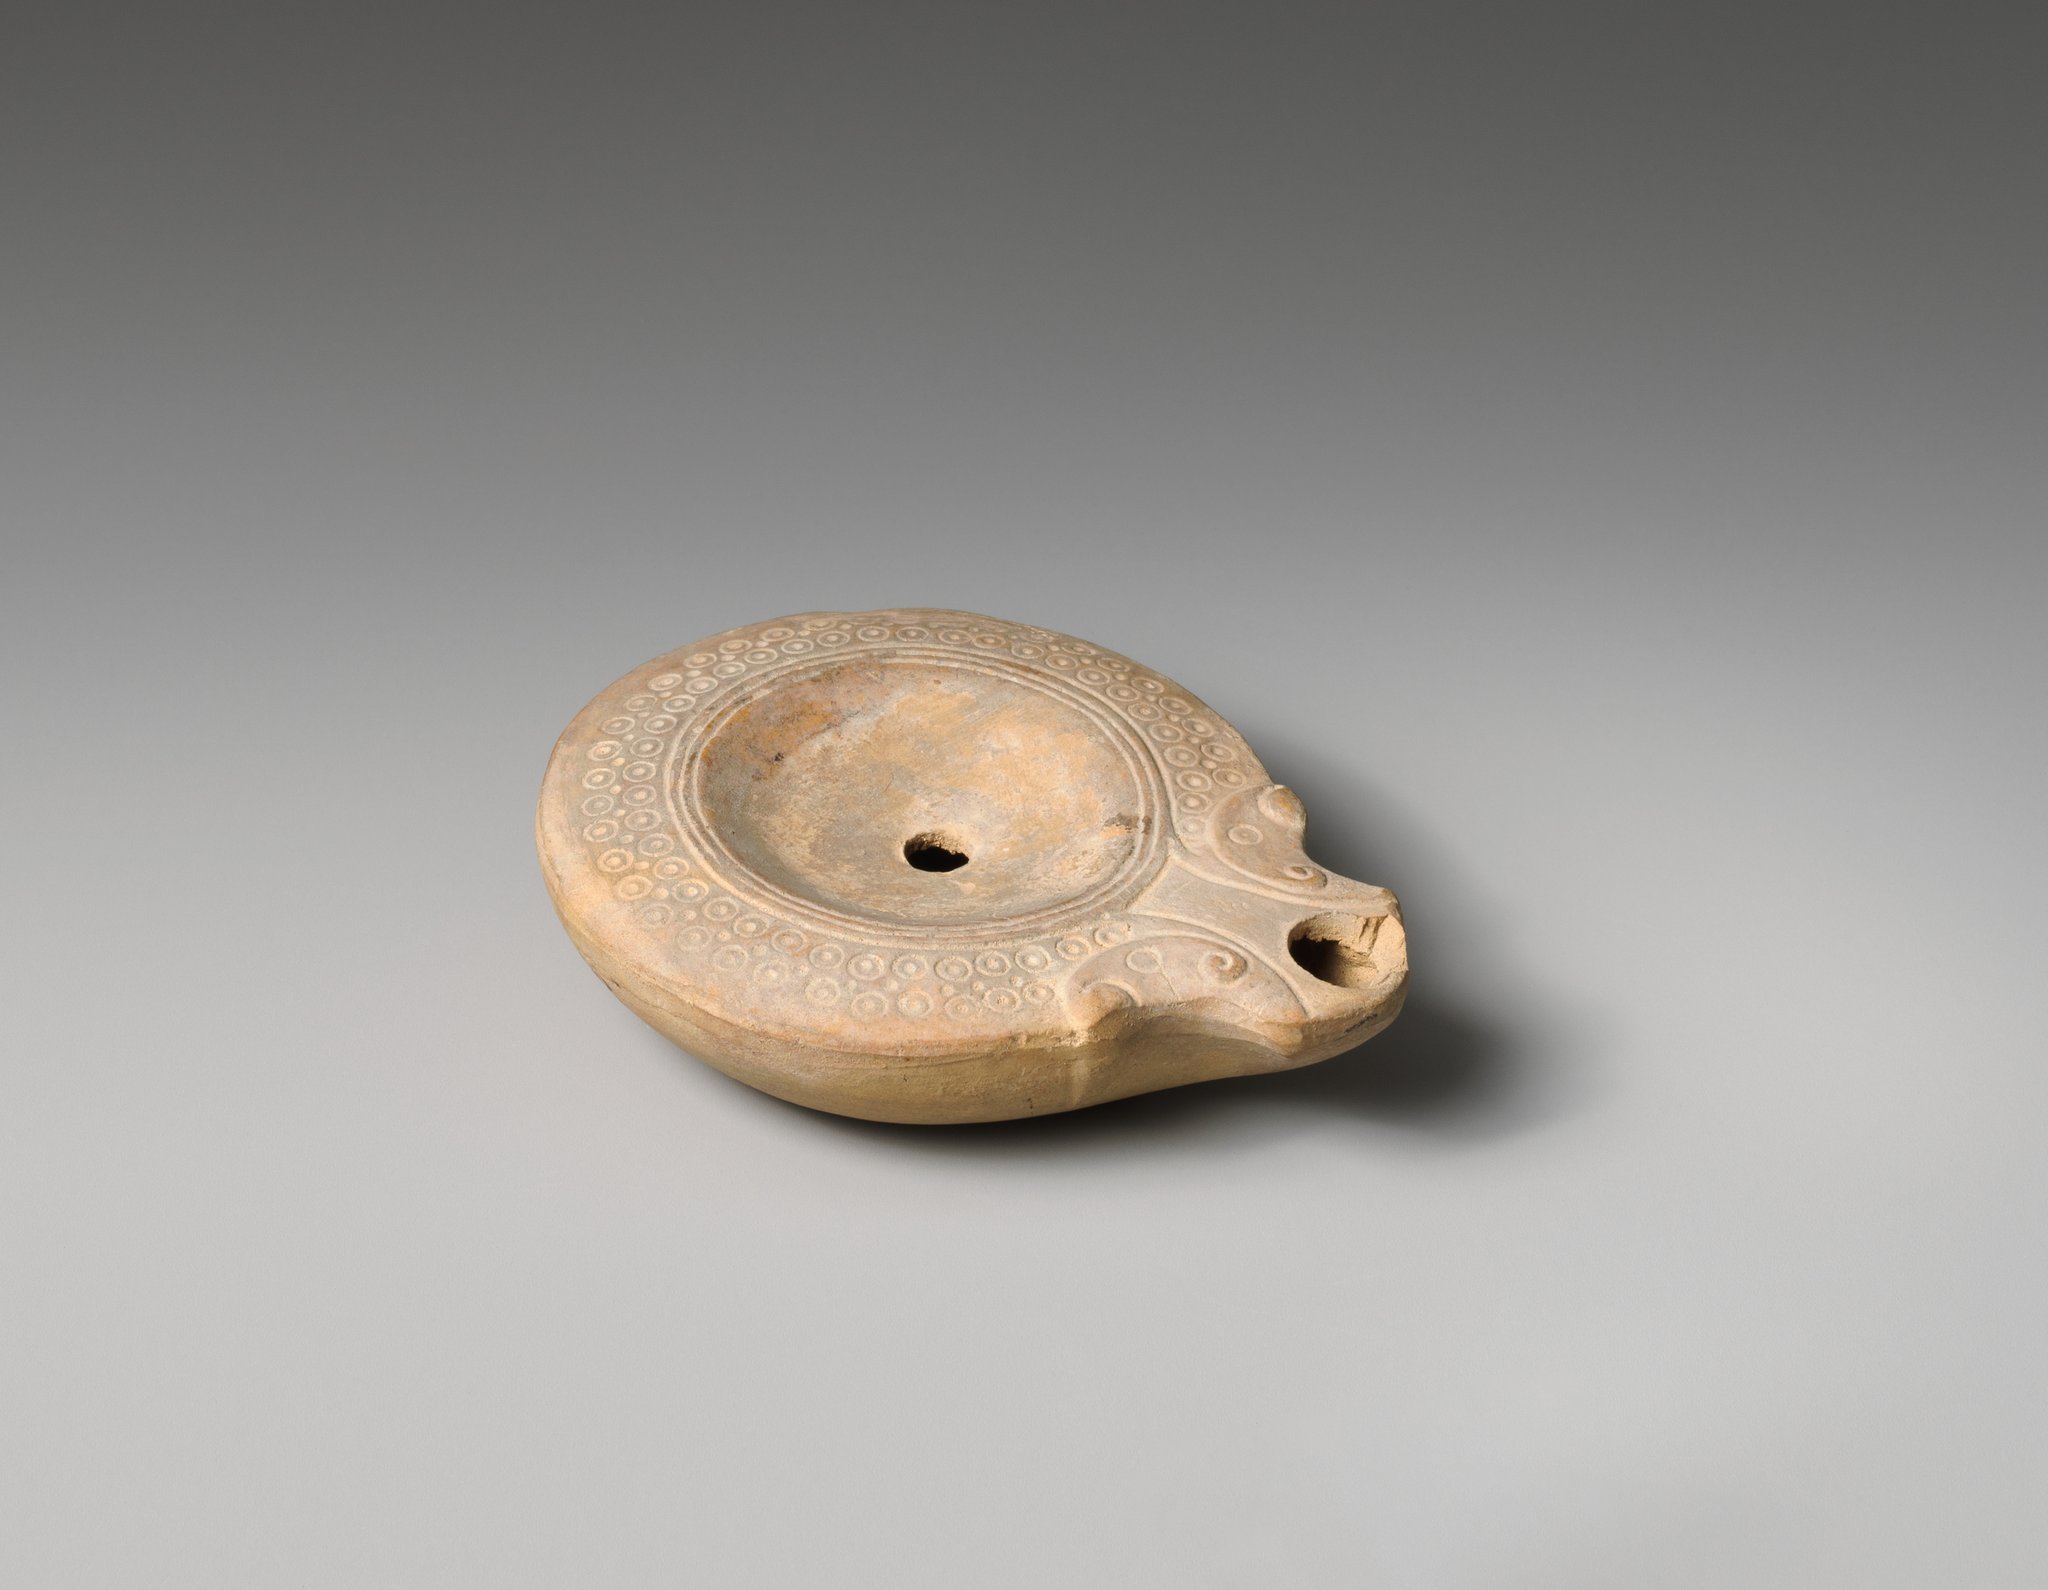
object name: lamp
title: Terracotta oil lamp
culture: roman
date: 1-200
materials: terracotta